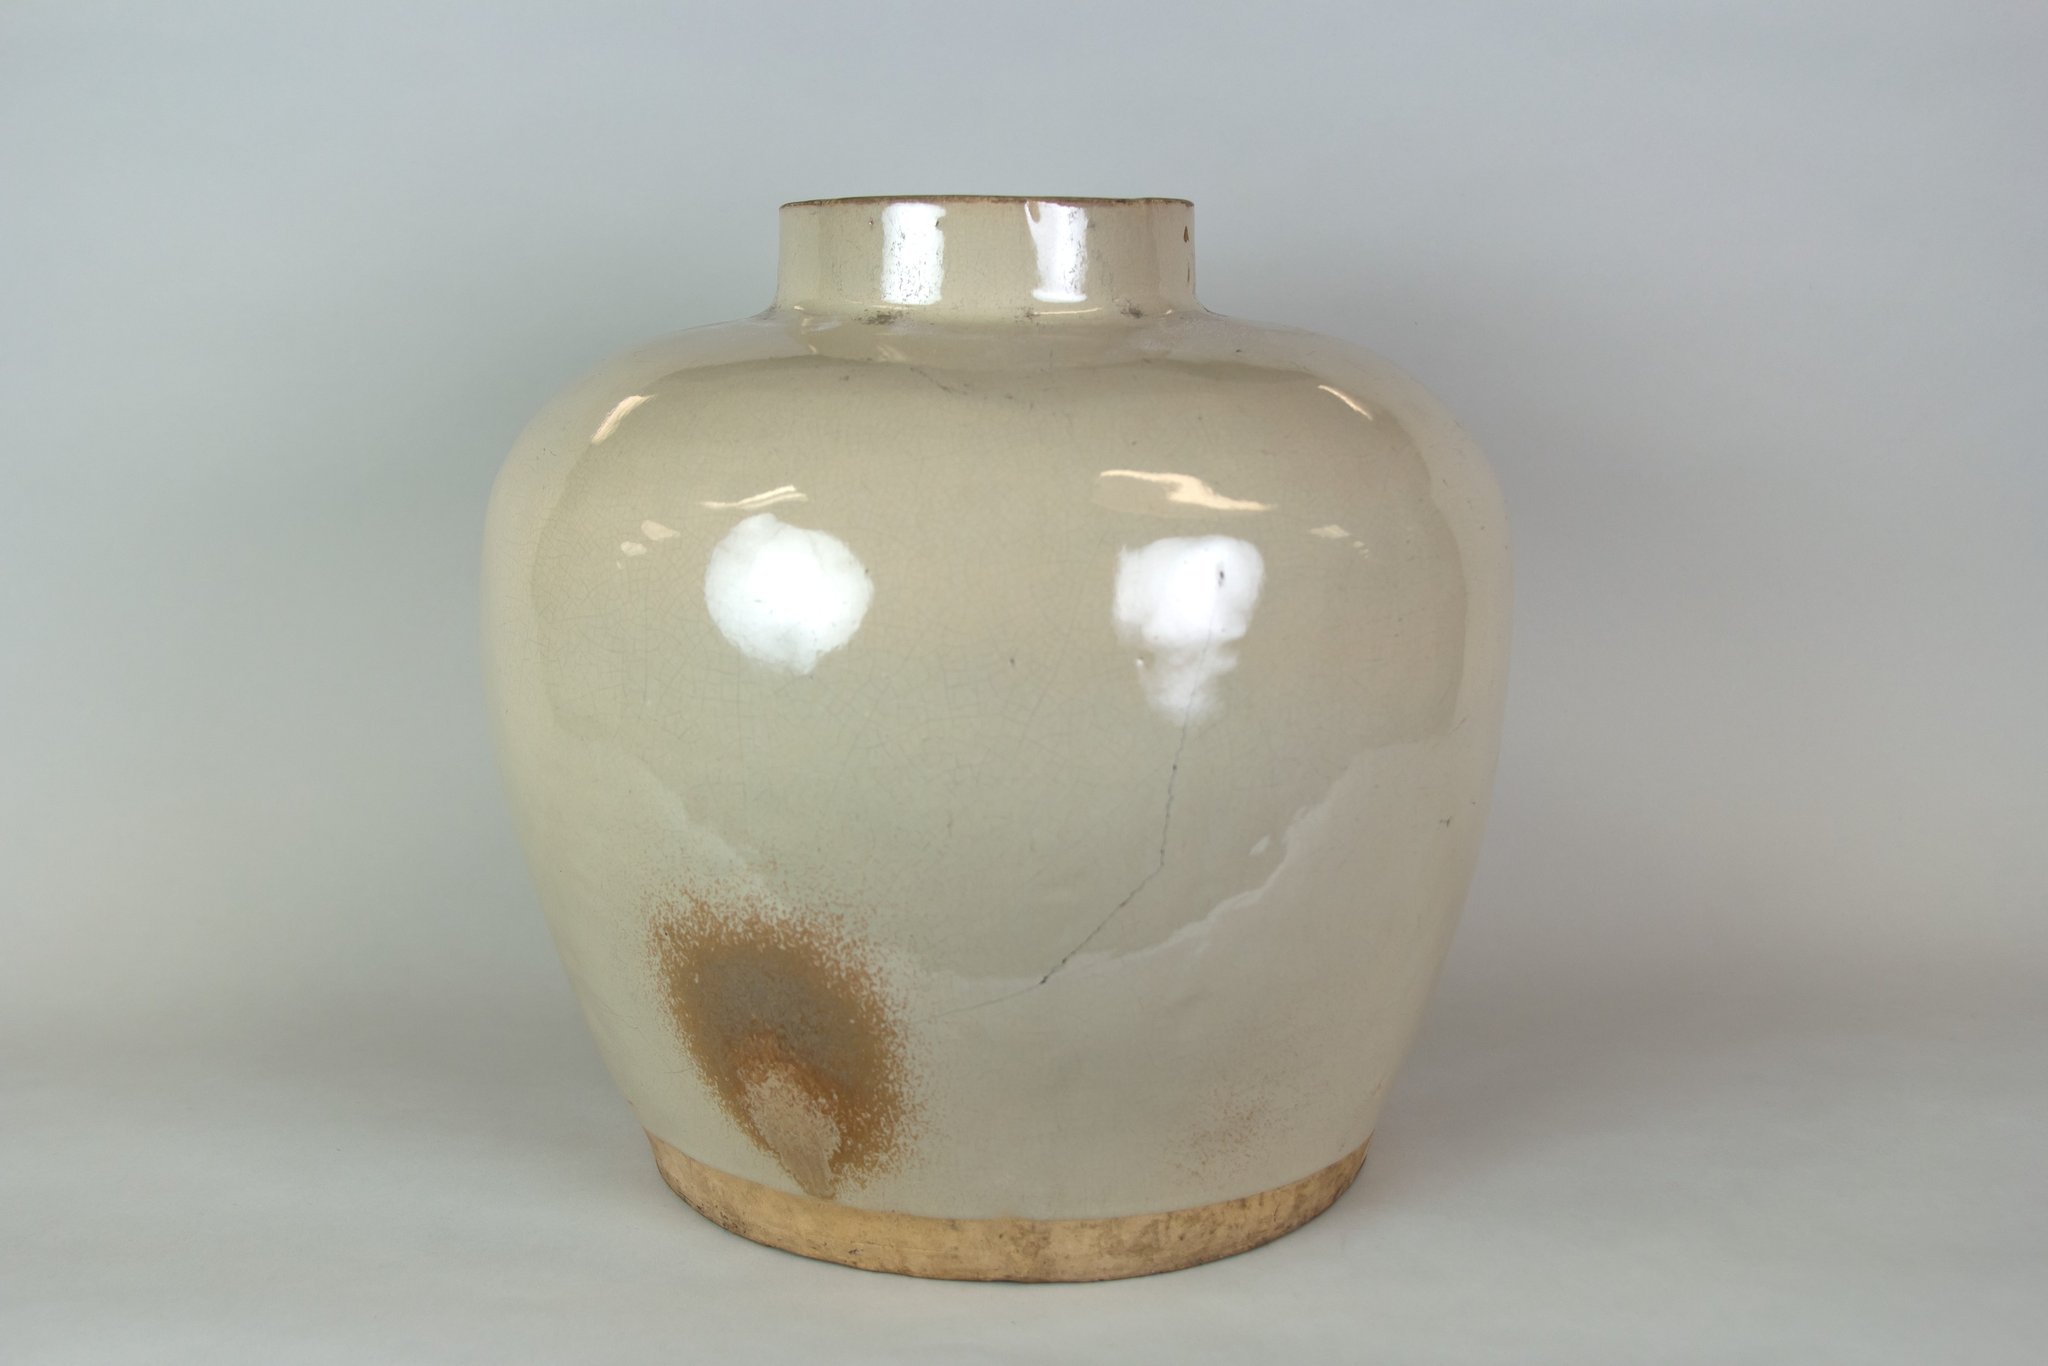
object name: jar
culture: chinese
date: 1368-1644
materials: glaze, porcelain